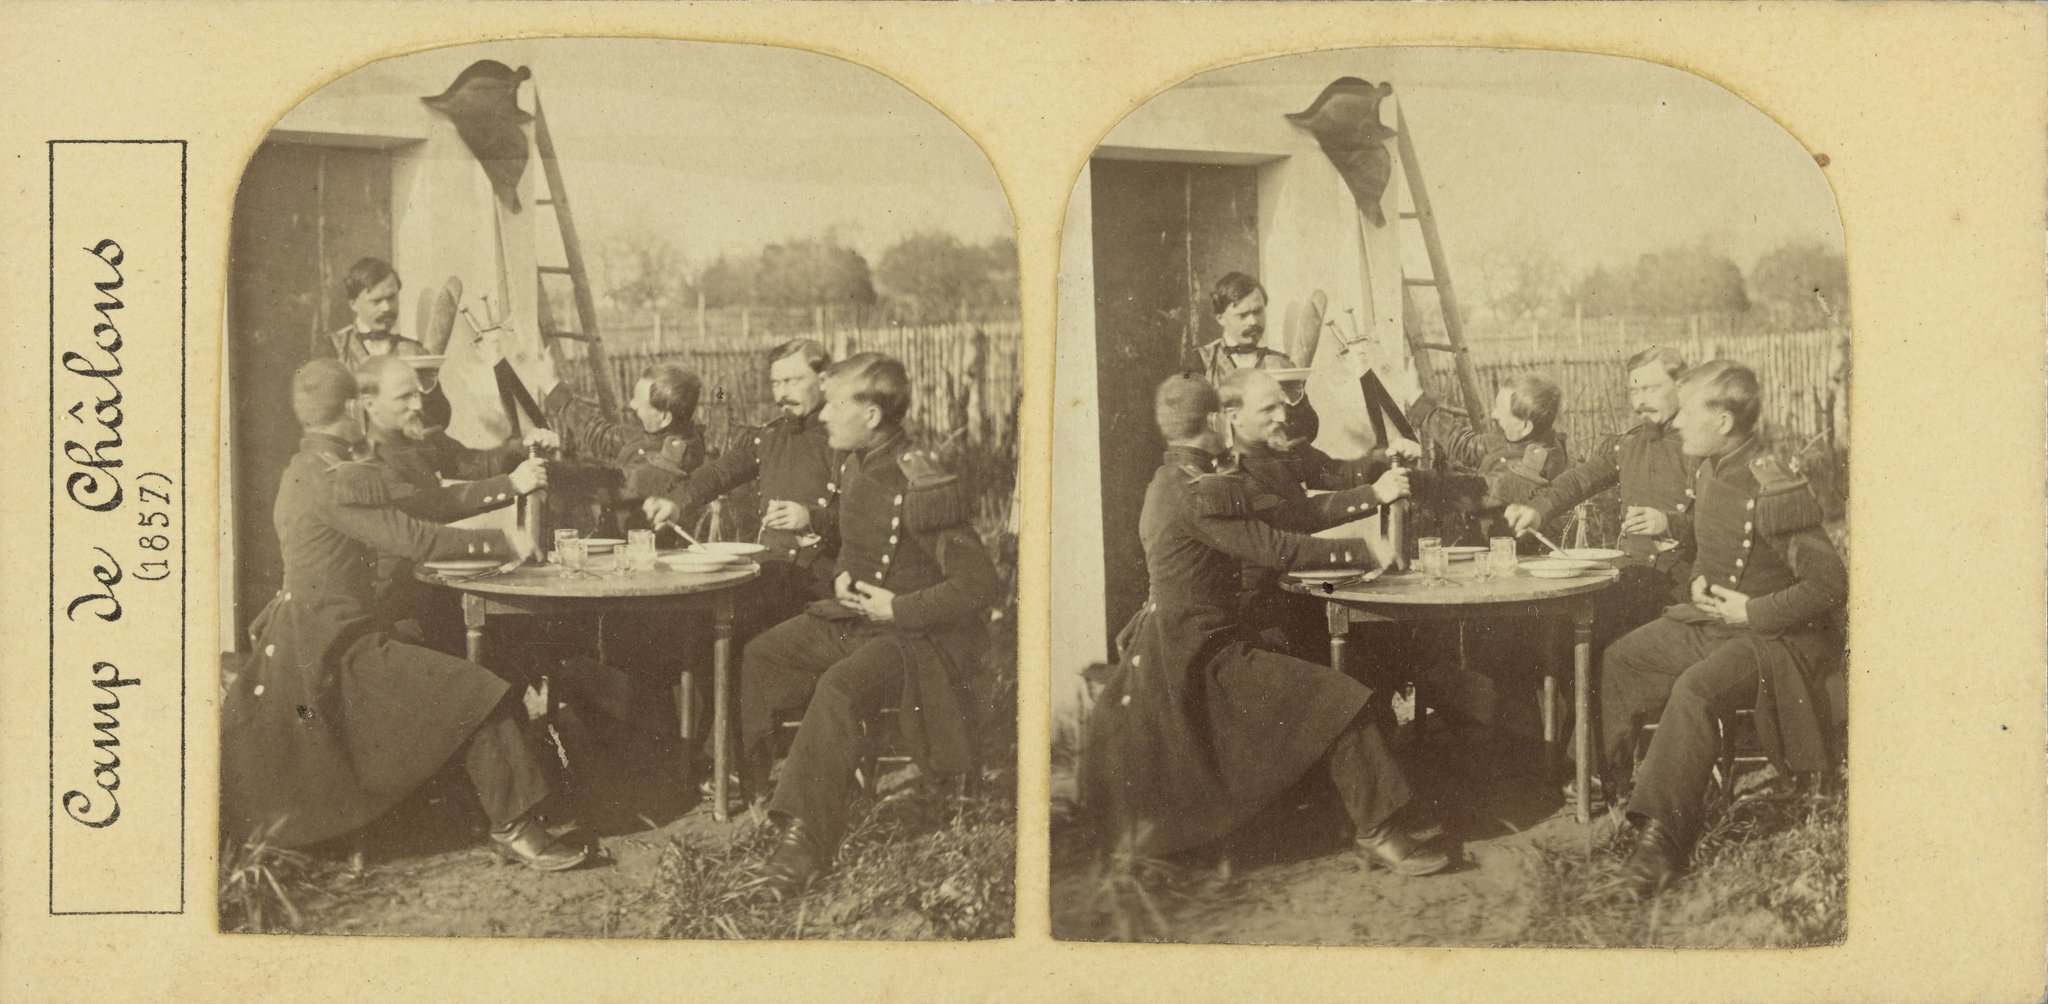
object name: stereograph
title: Camp de Châlons (1857)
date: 1857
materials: cardboard, paper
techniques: albumen print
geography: châlons-en-champagne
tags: (military) camp with tents, the soldier; the soldier's life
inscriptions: label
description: Officieren voor hun tent aan de maaltijd